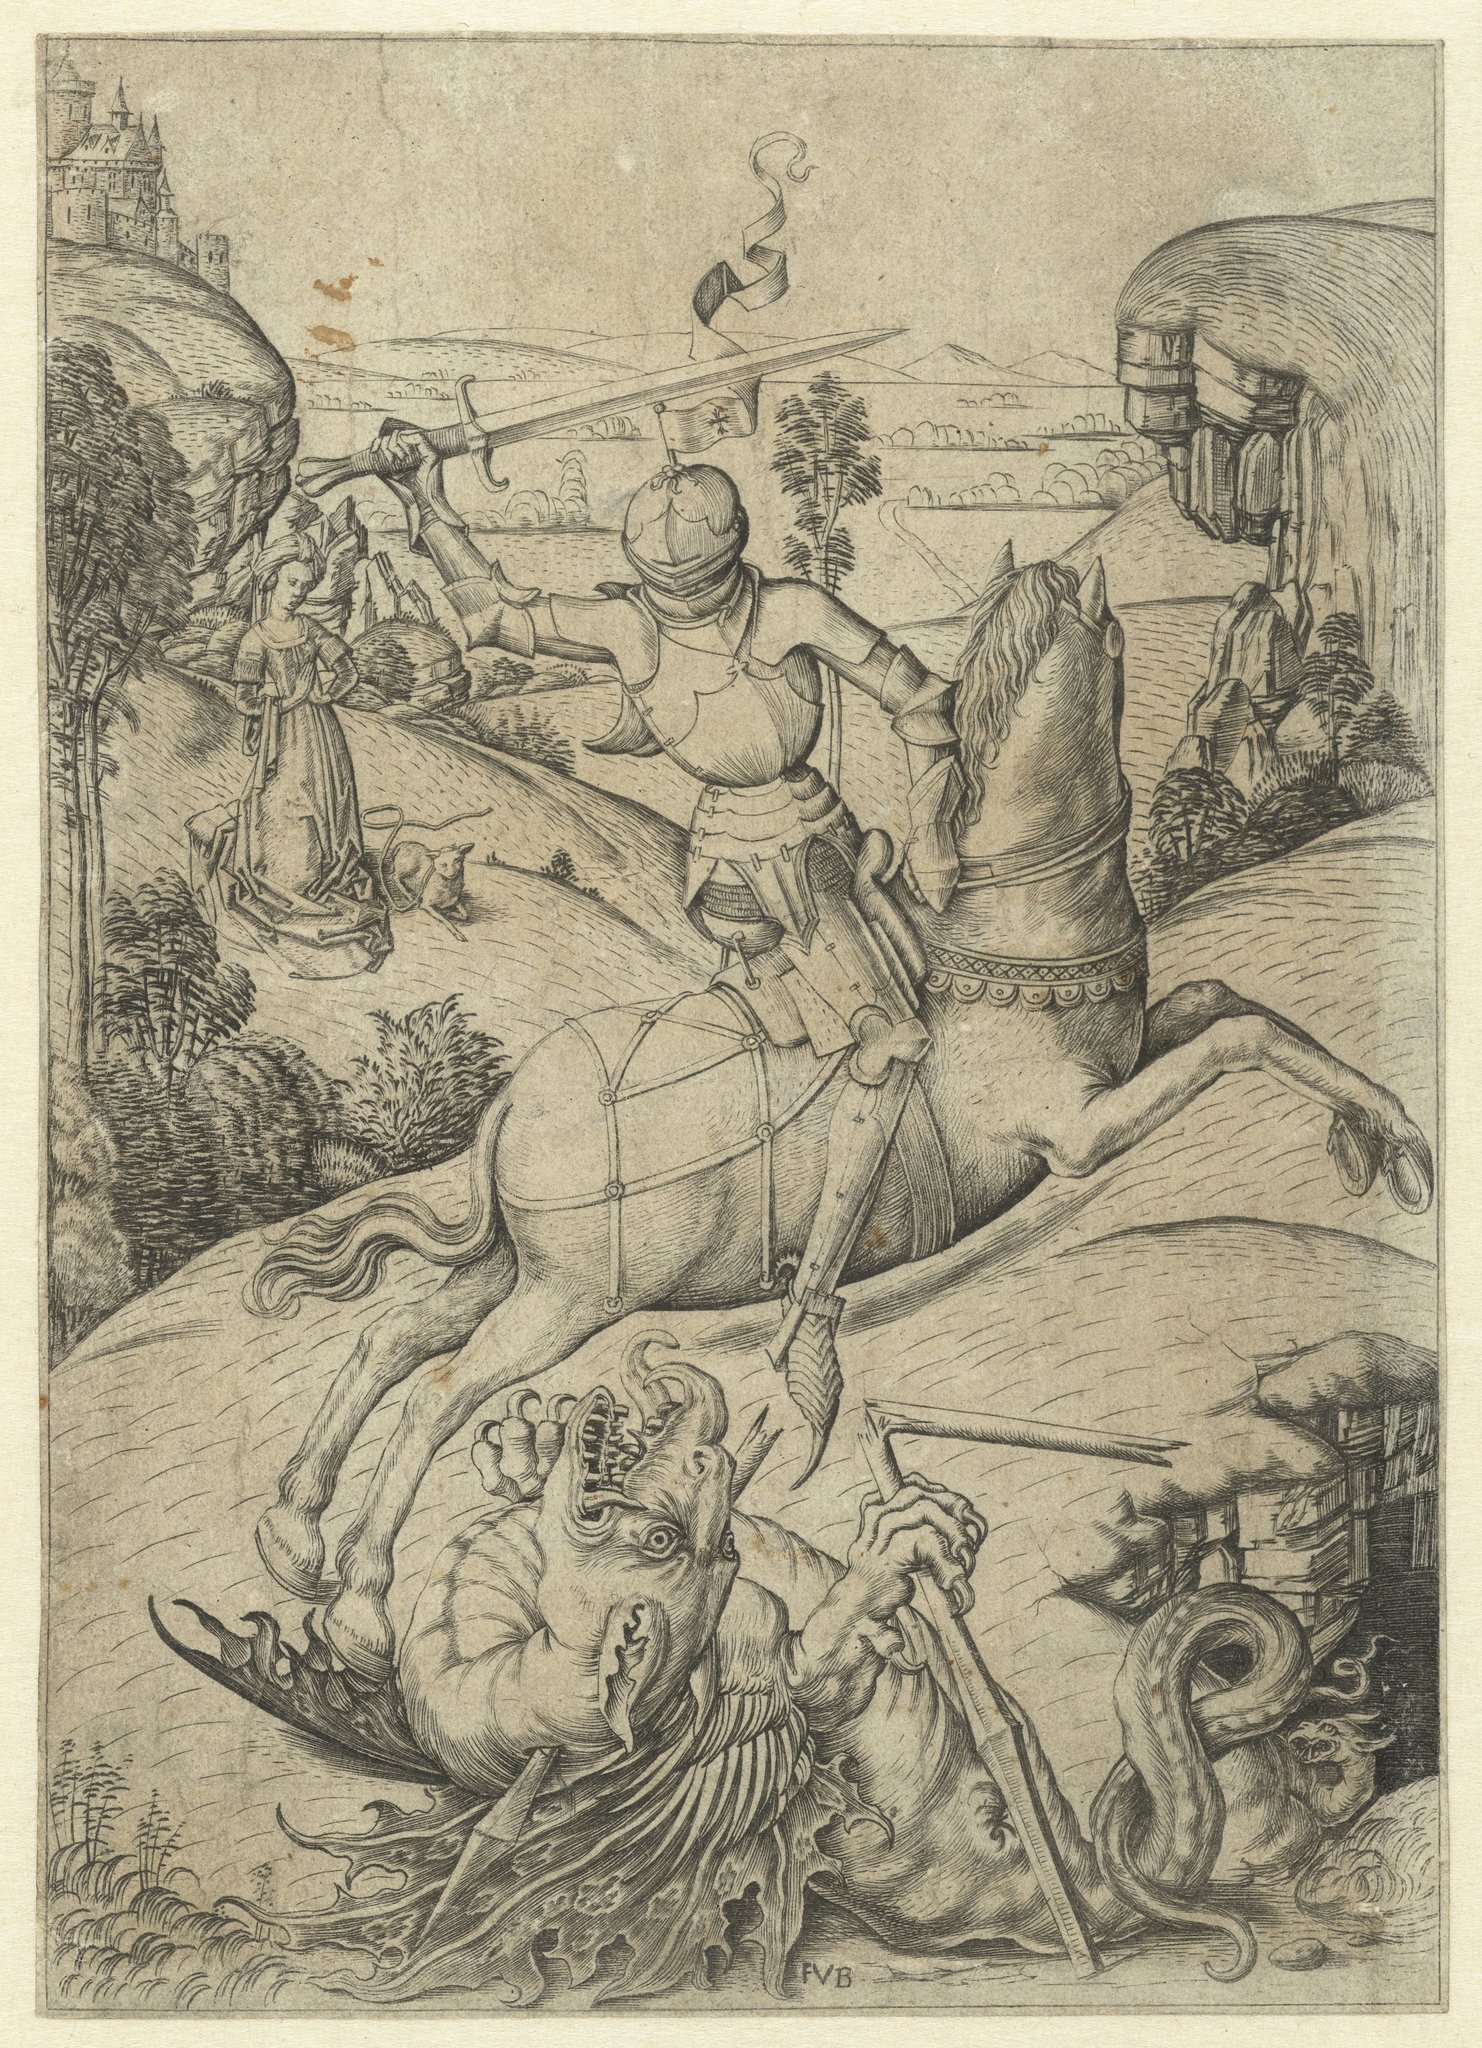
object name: print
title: Heilige Joris en de draak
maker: meester fvb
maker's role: print maker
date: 1475-1500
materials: paper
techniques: engraving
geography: low countries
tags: st. george and the dragon: dressed in armour and mounted on a (white) horse he brandishes his sword (his lance lies already broken on the ground); the princess nearby may be shown praying or fleeing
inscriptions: collector's mark: Lugt 2228a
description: Joris te paard met opgeheven zwaard. Onder hem Draak met gebroken lans. Landschap op achtergrond met vrouw en lam.